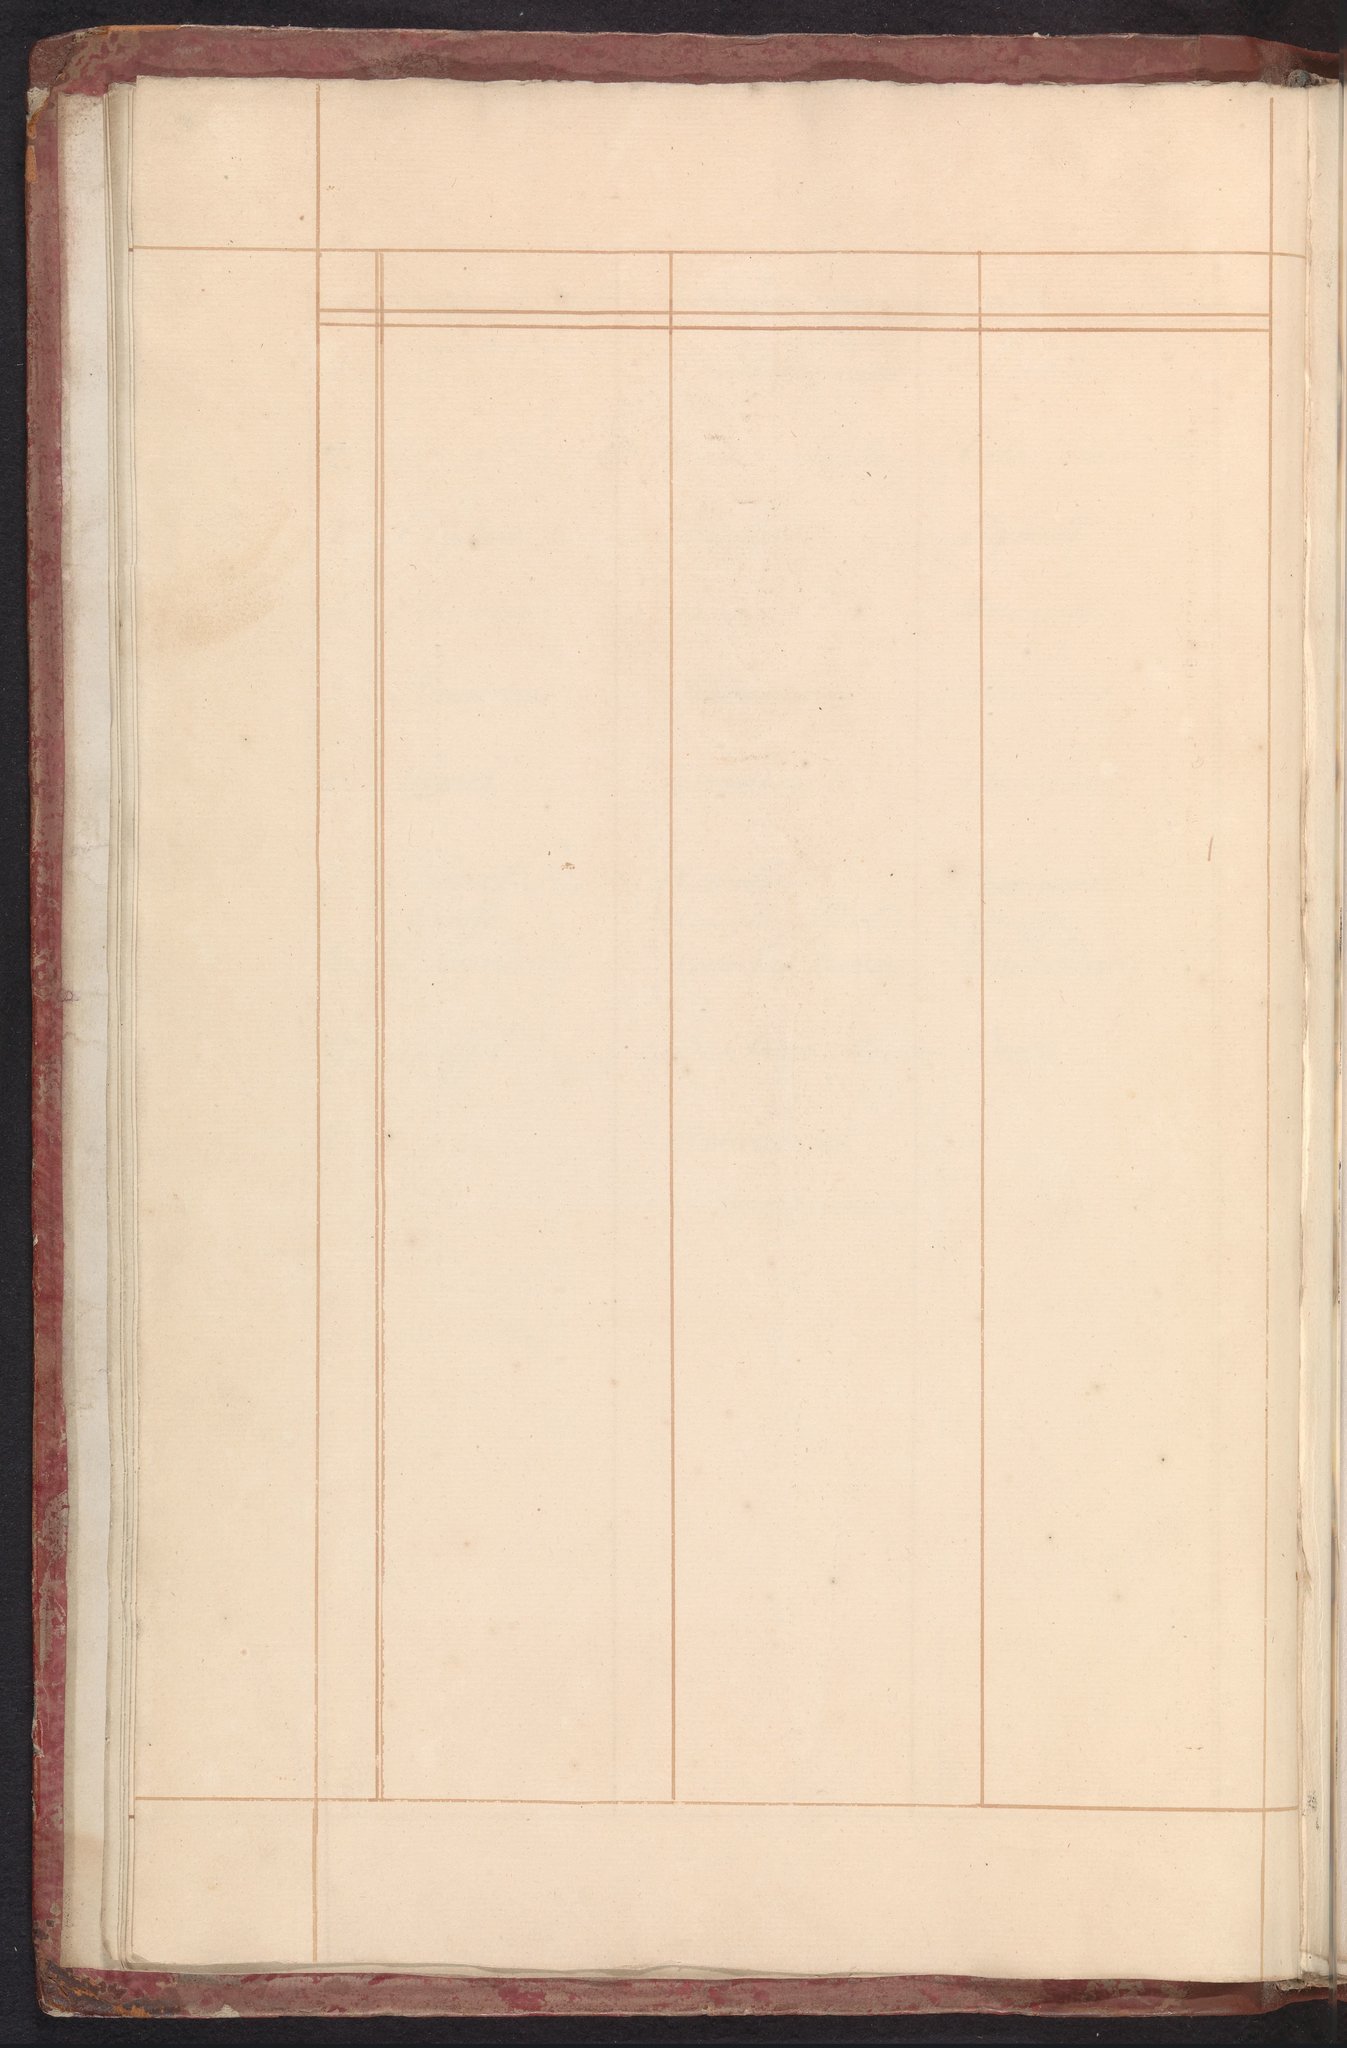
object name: manuscript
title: Oningevuld schema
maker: joseph van huerne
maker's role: kunstliefhebber, mecenas, verzamelaar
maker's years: 1752-1844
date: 1809-1814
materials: ink, paper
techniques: pen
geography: bruges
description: Oningevuld schema met drie kolommen. Onderdeel van het tweede album met tekeningen van viervoeters. Tweede van twaalf albums met tekeningen van dieren, vogels en planten bekend rond 1600, gemaakt in opdracht van keizer Rudolf II. Met toelichting in Nederlands, Latijn en Frans.